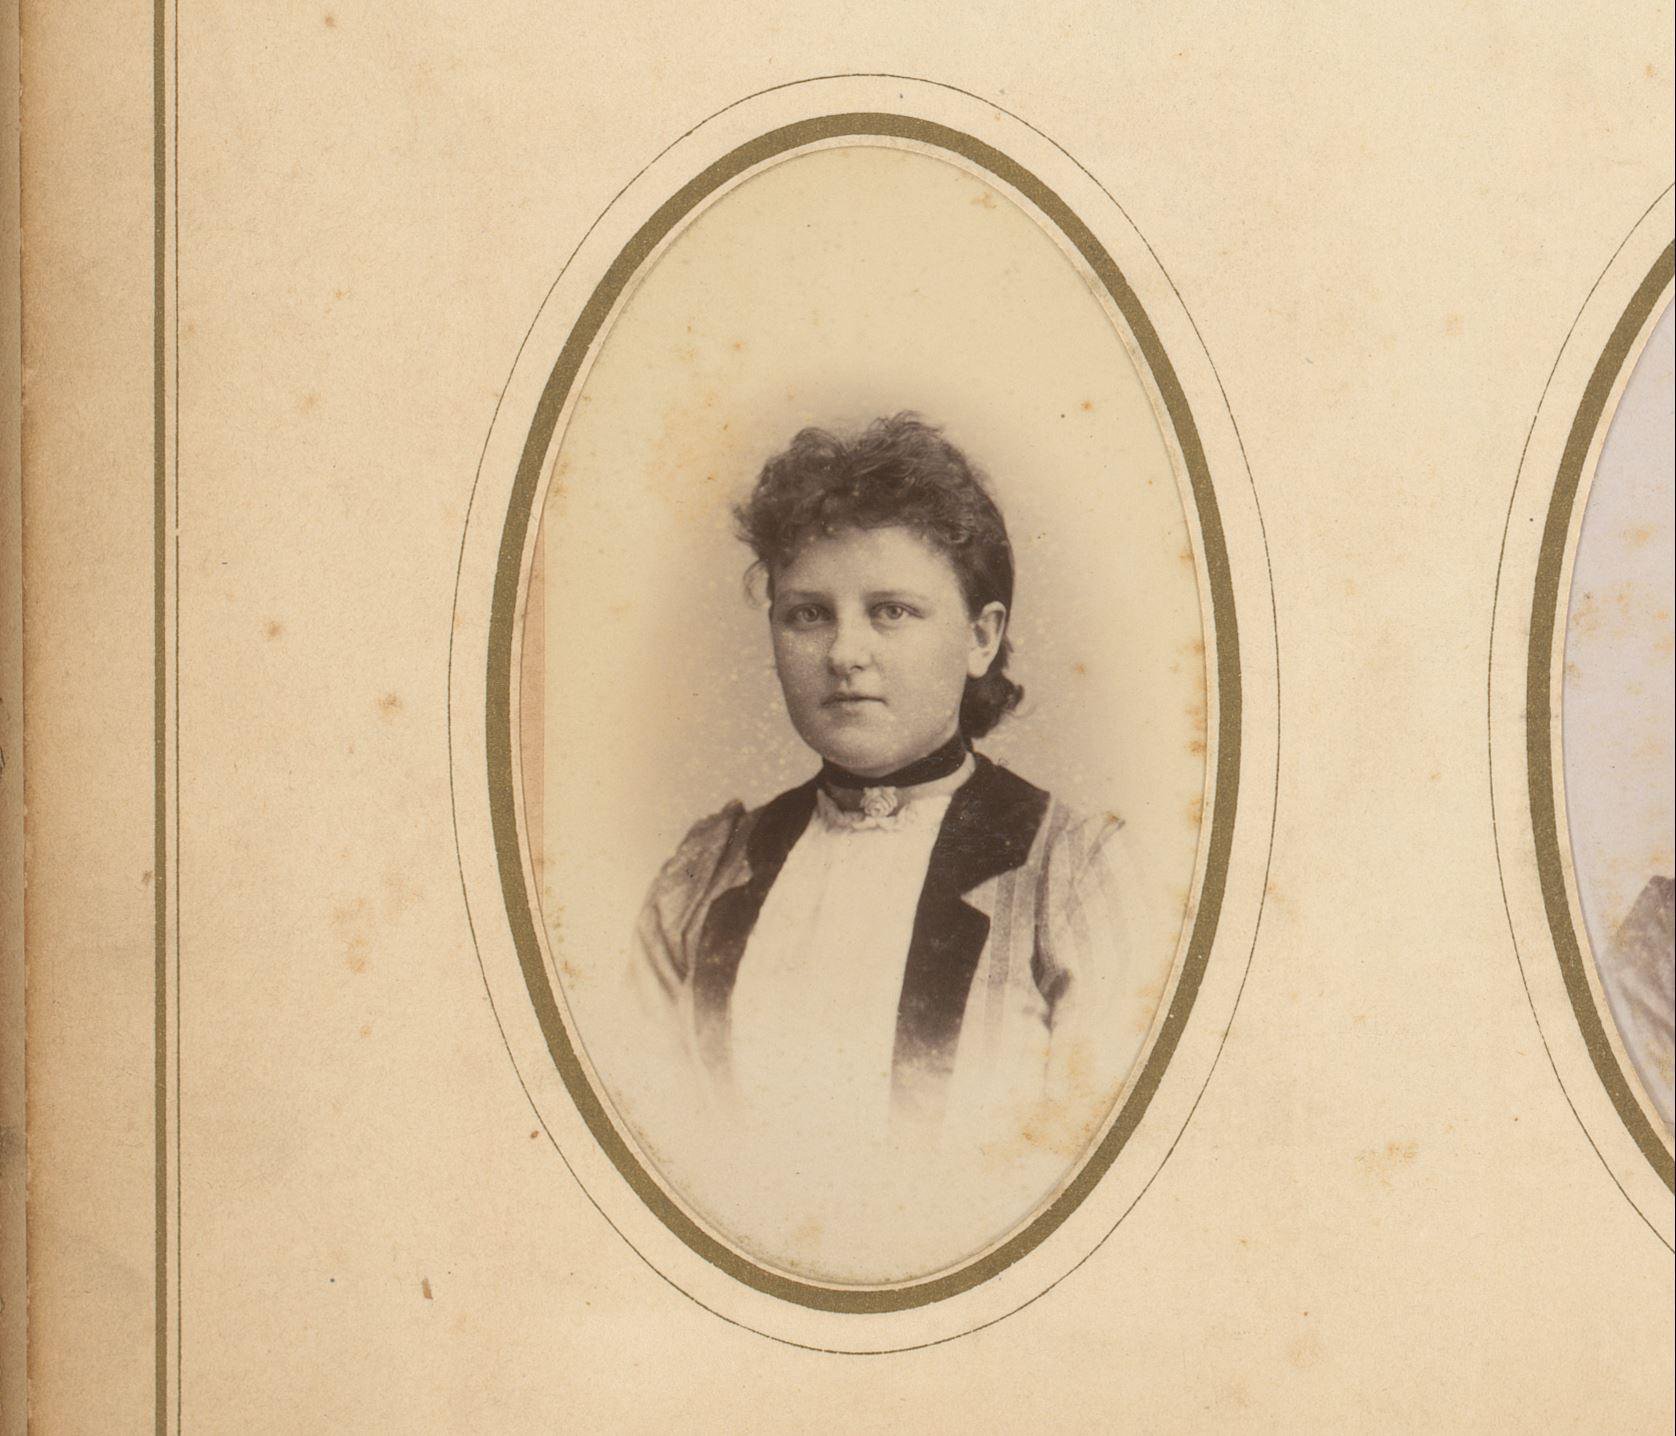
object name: album leaf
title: Portret van een jonge vrouw met halsketting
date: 1860-1900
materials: cardboard, photographic support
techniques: albumen print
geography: groningen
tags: historical persons - bb - woman, necklace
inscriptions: inscription: ‘Gebr. Sanders/ Photographie Instantanée/ Groningen/ Hoek Stoeldraaierstraat H. 13./ 2 de huis Kromme Elleboog./ Specialiteit in vergrootingen,/ de negativen blyven ter nabestelling bewaard.’